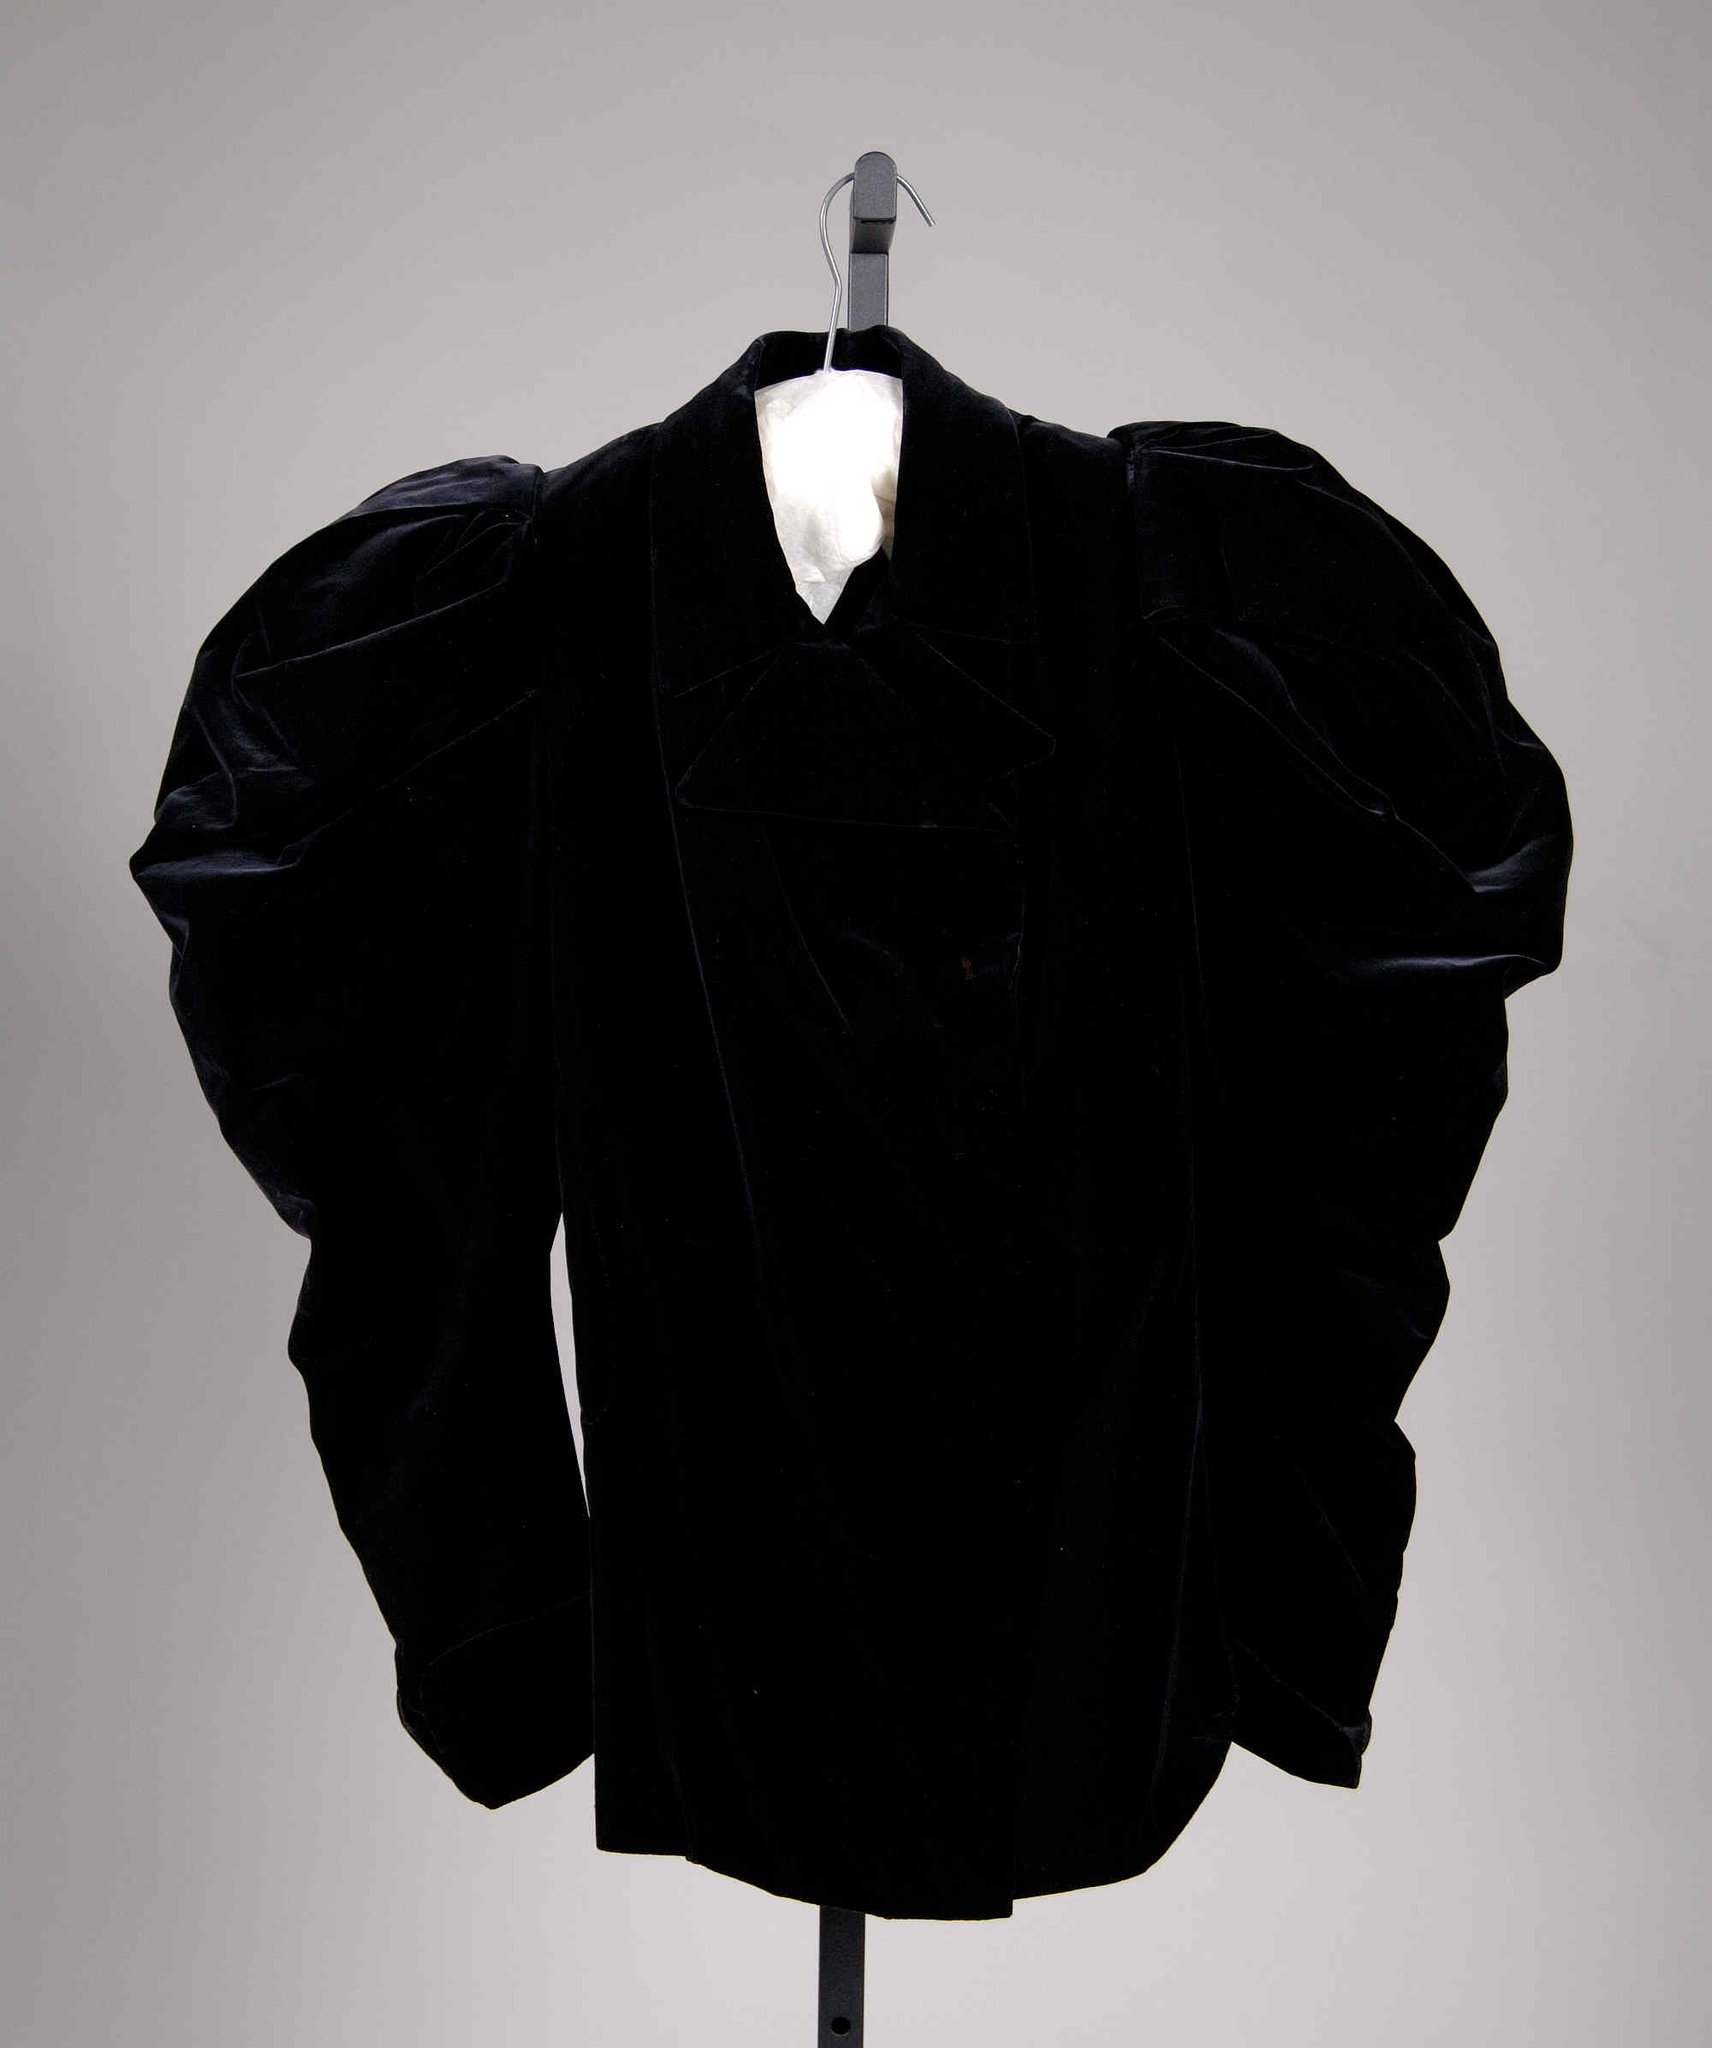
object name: jacket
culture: french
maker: richards & veryken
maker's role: maker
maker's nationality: french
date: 1895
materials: silk